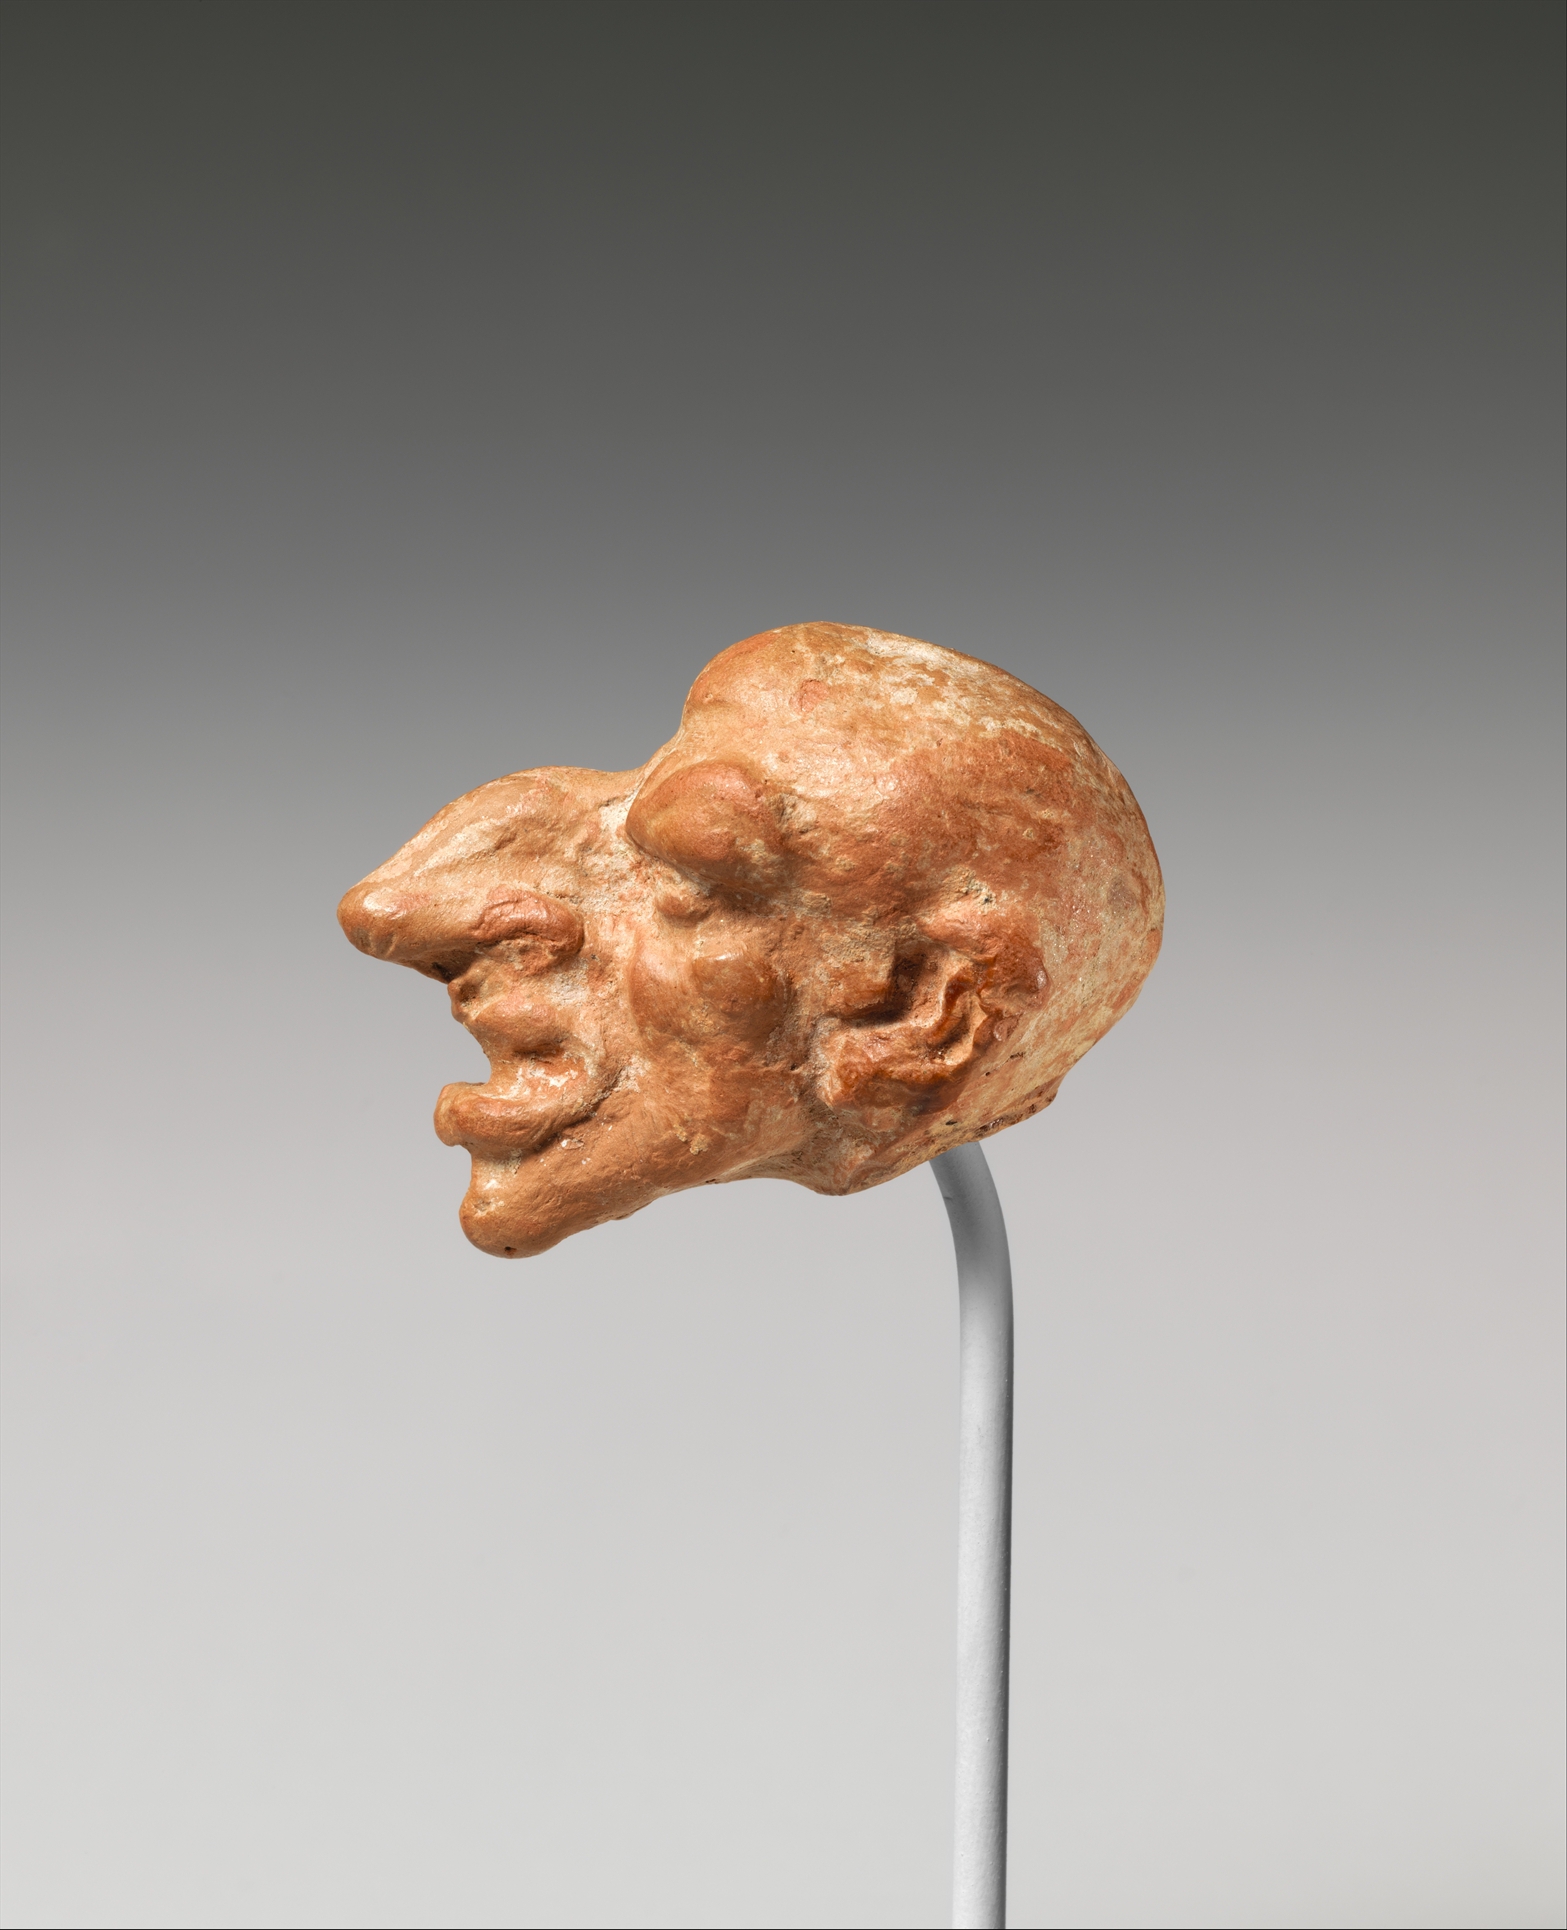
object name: head of a male dwarf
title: Terracotta head of a male dwarf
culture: greek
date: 200-101 BCE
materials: terracotta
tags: heads,men